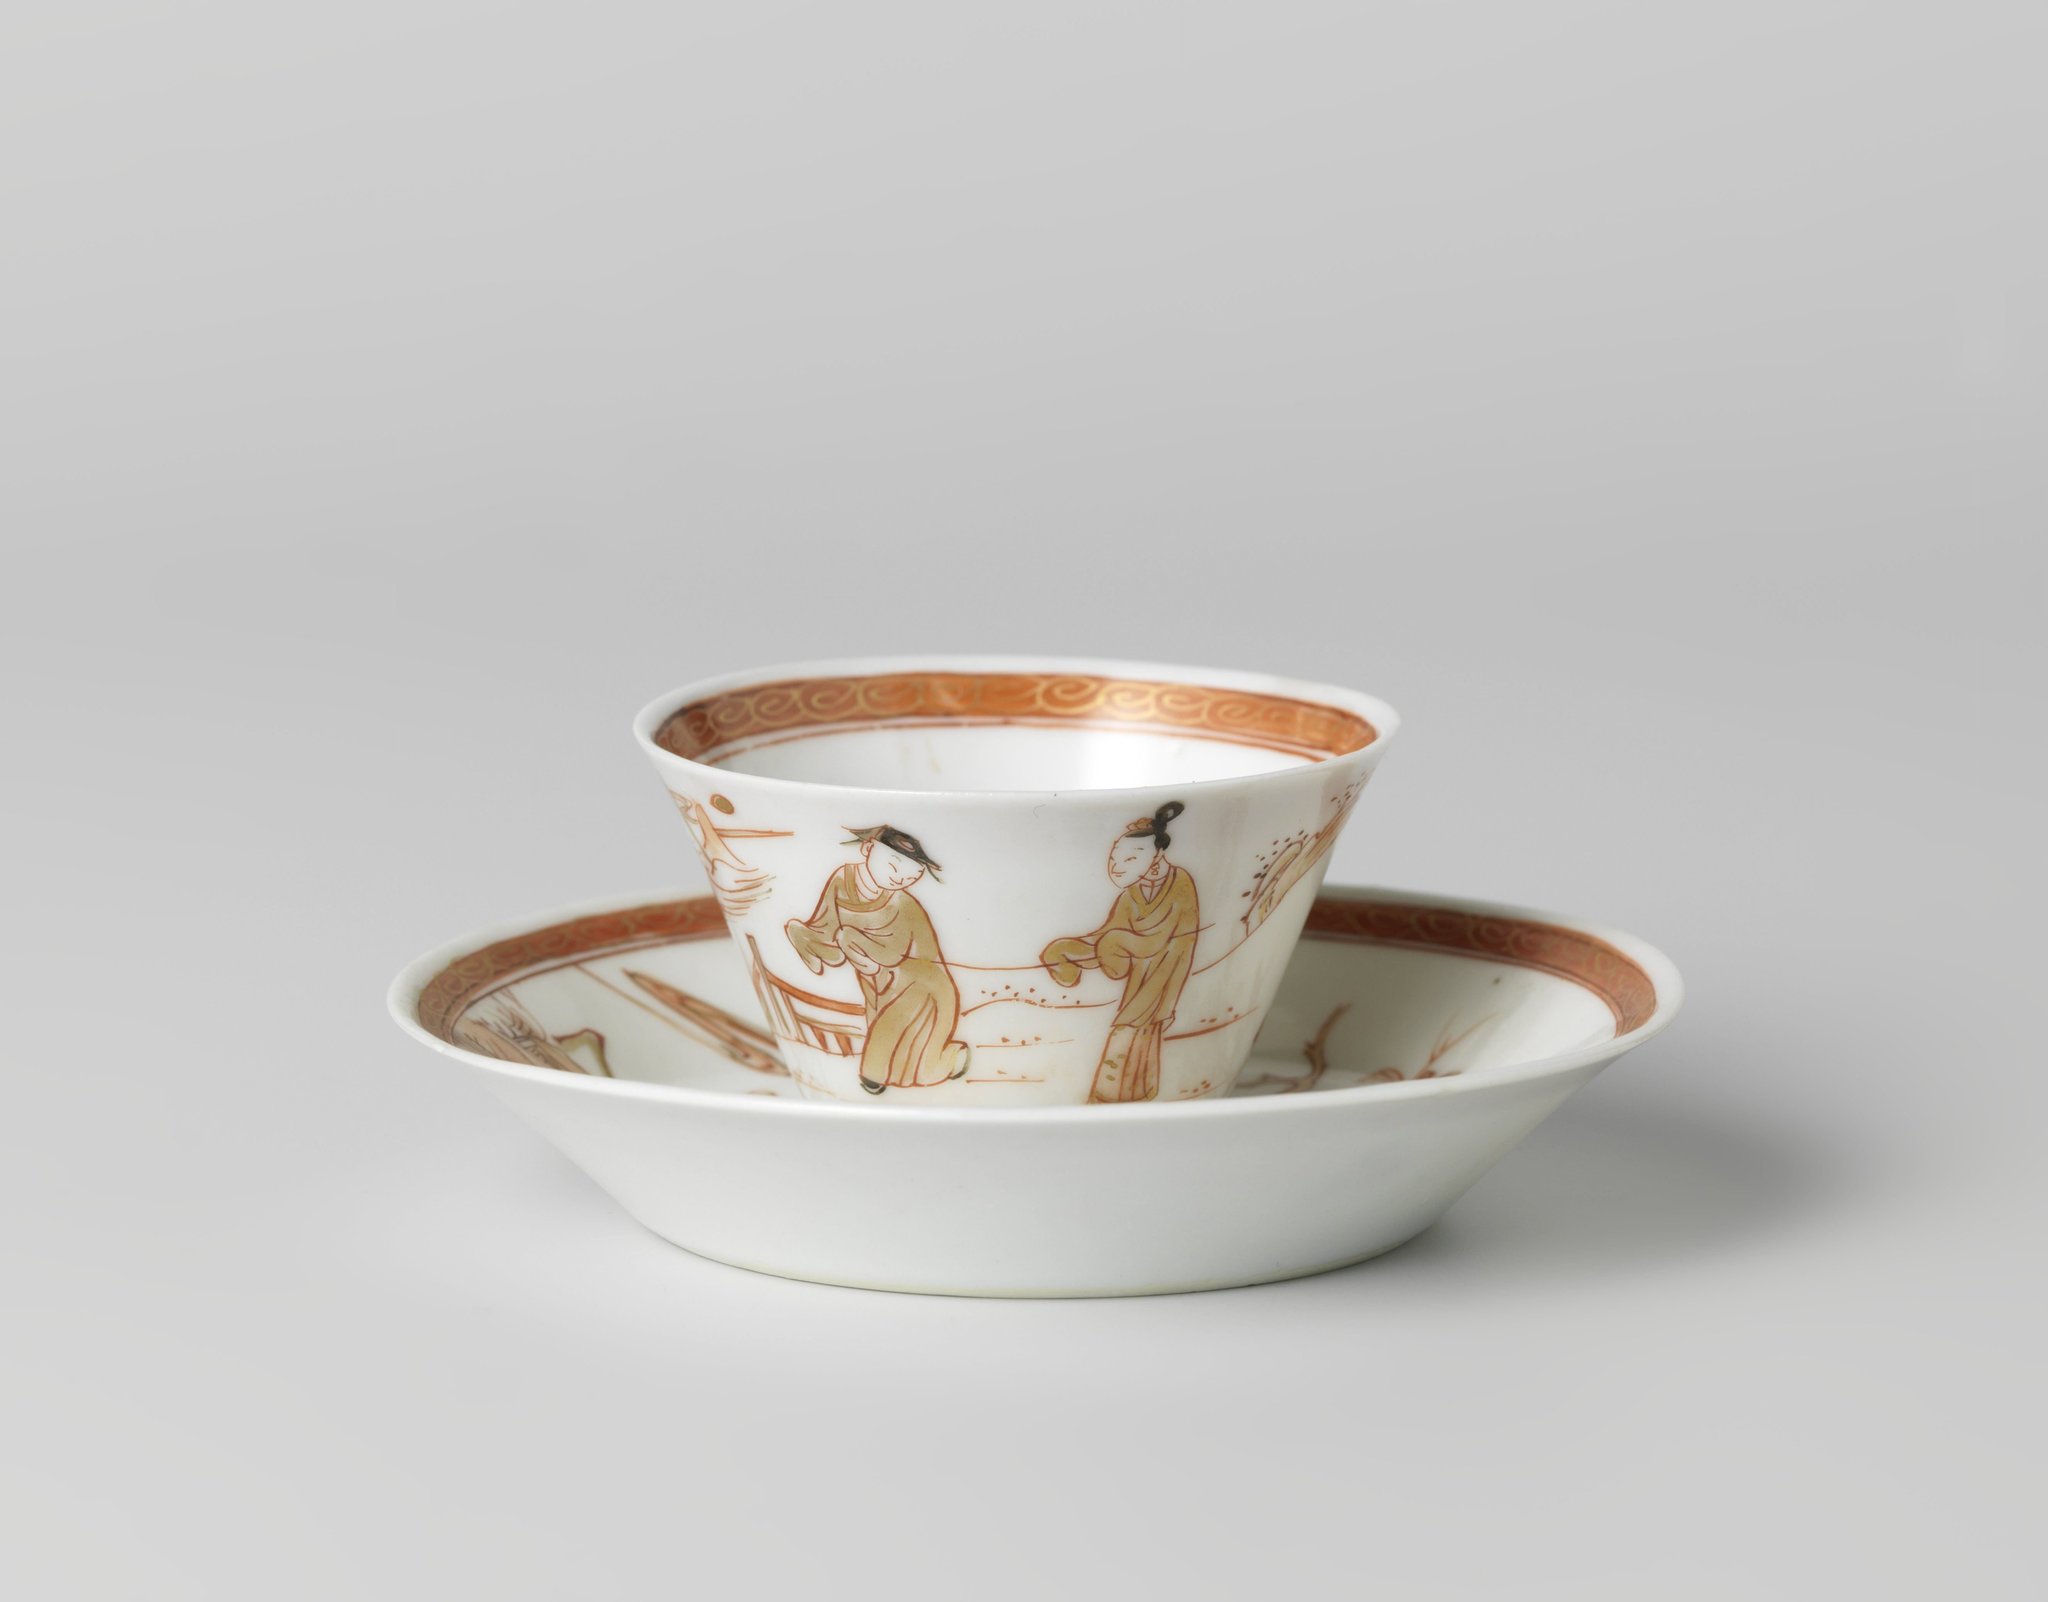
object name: kop en schotel, kop en schotel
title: Cup and saucer with two figures in a water landscape and a flowering tree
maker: Anonymous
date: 1700-1724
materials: glaze, gold, paint, porcelain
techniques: firing, gilding, turning, vitrification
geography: china